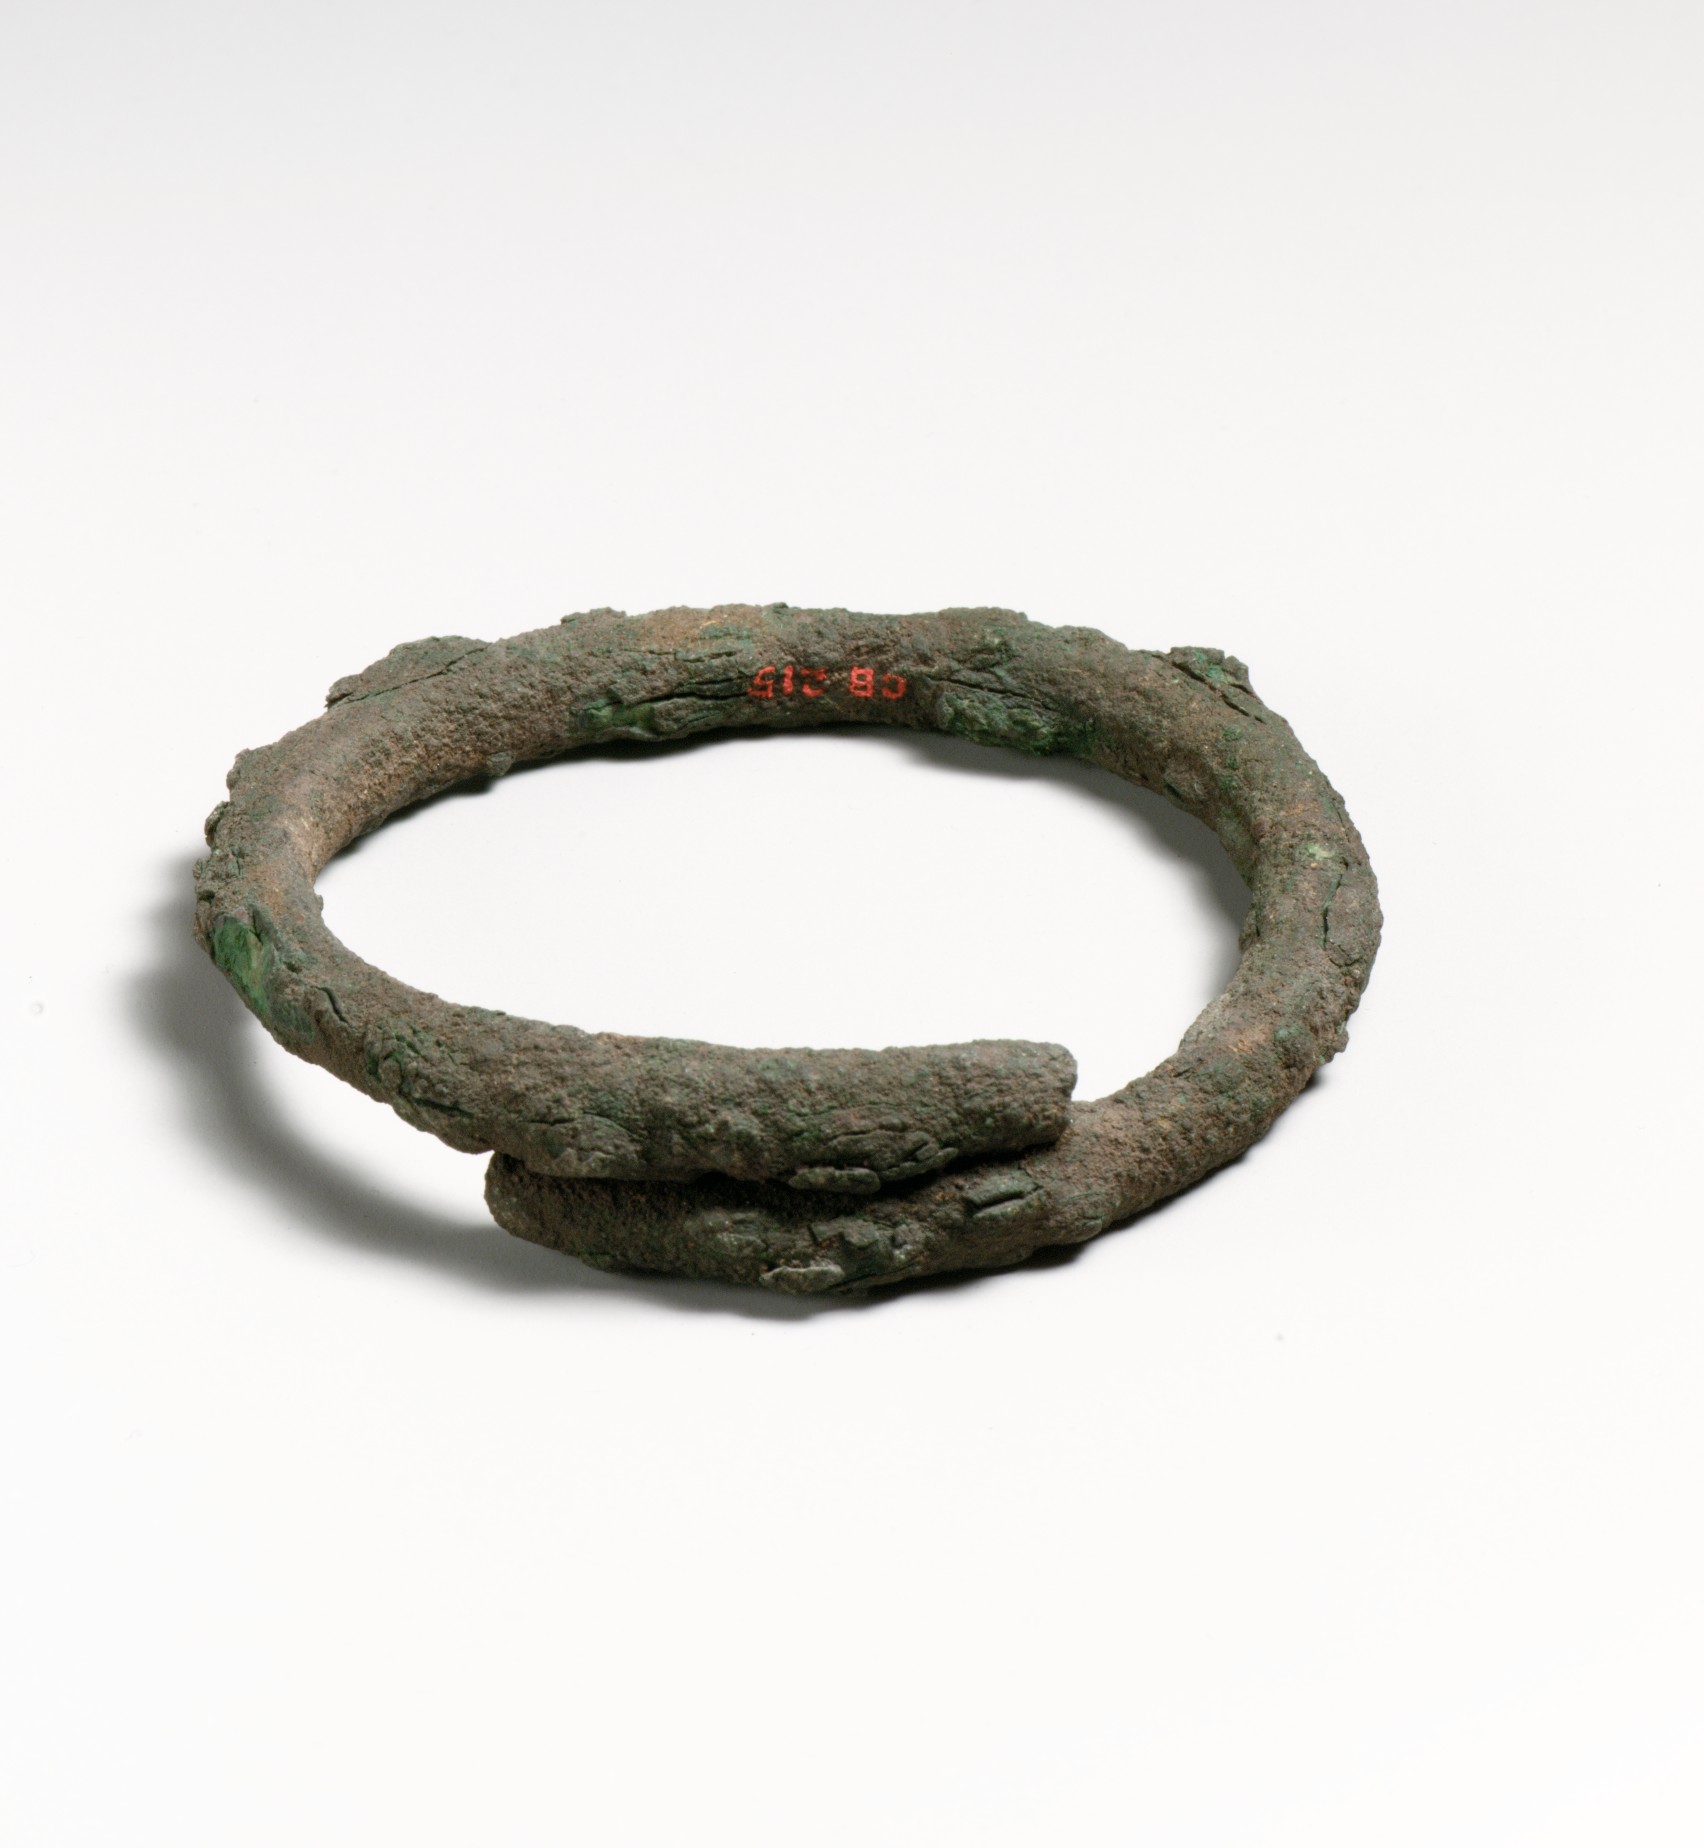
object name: bracelet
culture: cypriot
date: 600-401 BCE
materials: bronze